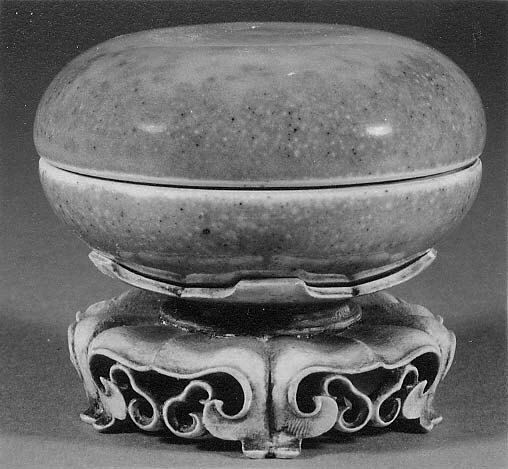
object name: box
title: Rouge Box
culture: chinese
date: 1662-1722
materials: glaze, porcelain